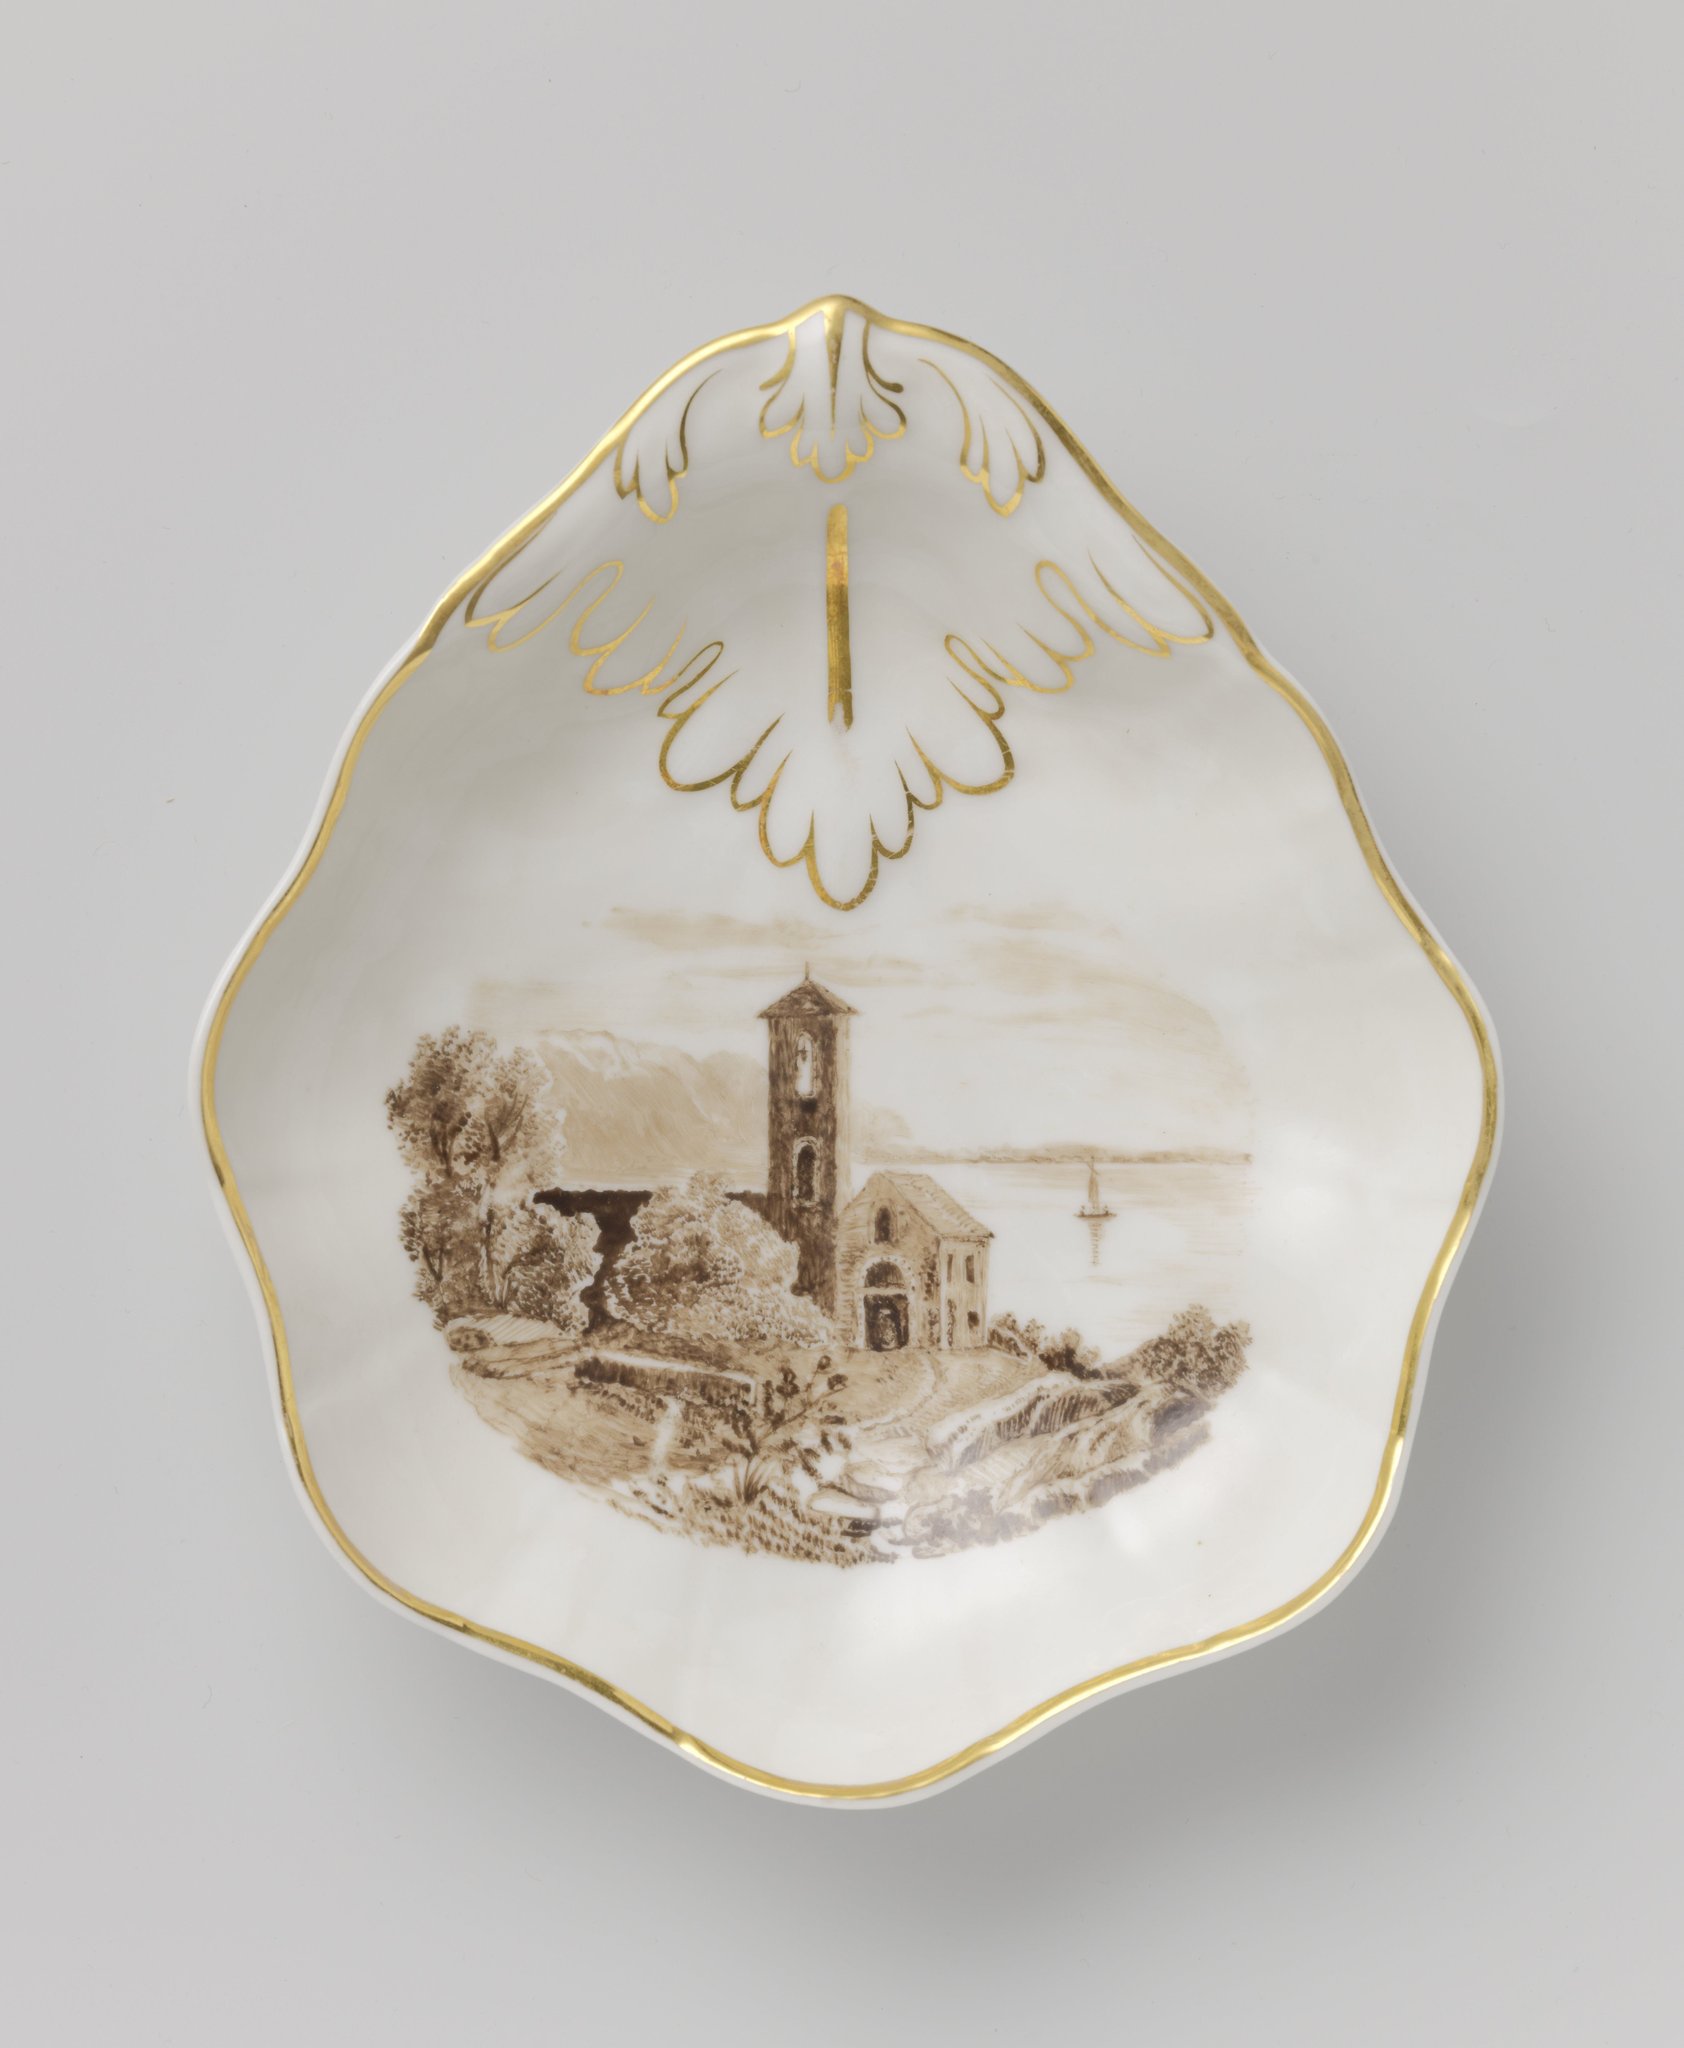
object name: service set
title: Dish with a landscape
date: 1850-1860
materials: glaze, gold, paint, porcelain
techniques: firing, forming, gilding, turning, vitrification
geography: europe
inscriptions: mark: ‘V?’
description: Bladvormige schaal van porselein, beschilderd op het glazuur in sepia en goud. Op de smalle zijde een gemodelleerd blad, aangezet met goud. Op het plat een waterlandschap met een kerk, boot, bomen en bergen. Gouden rand. Gemerkt op de onderzijde met V[?].